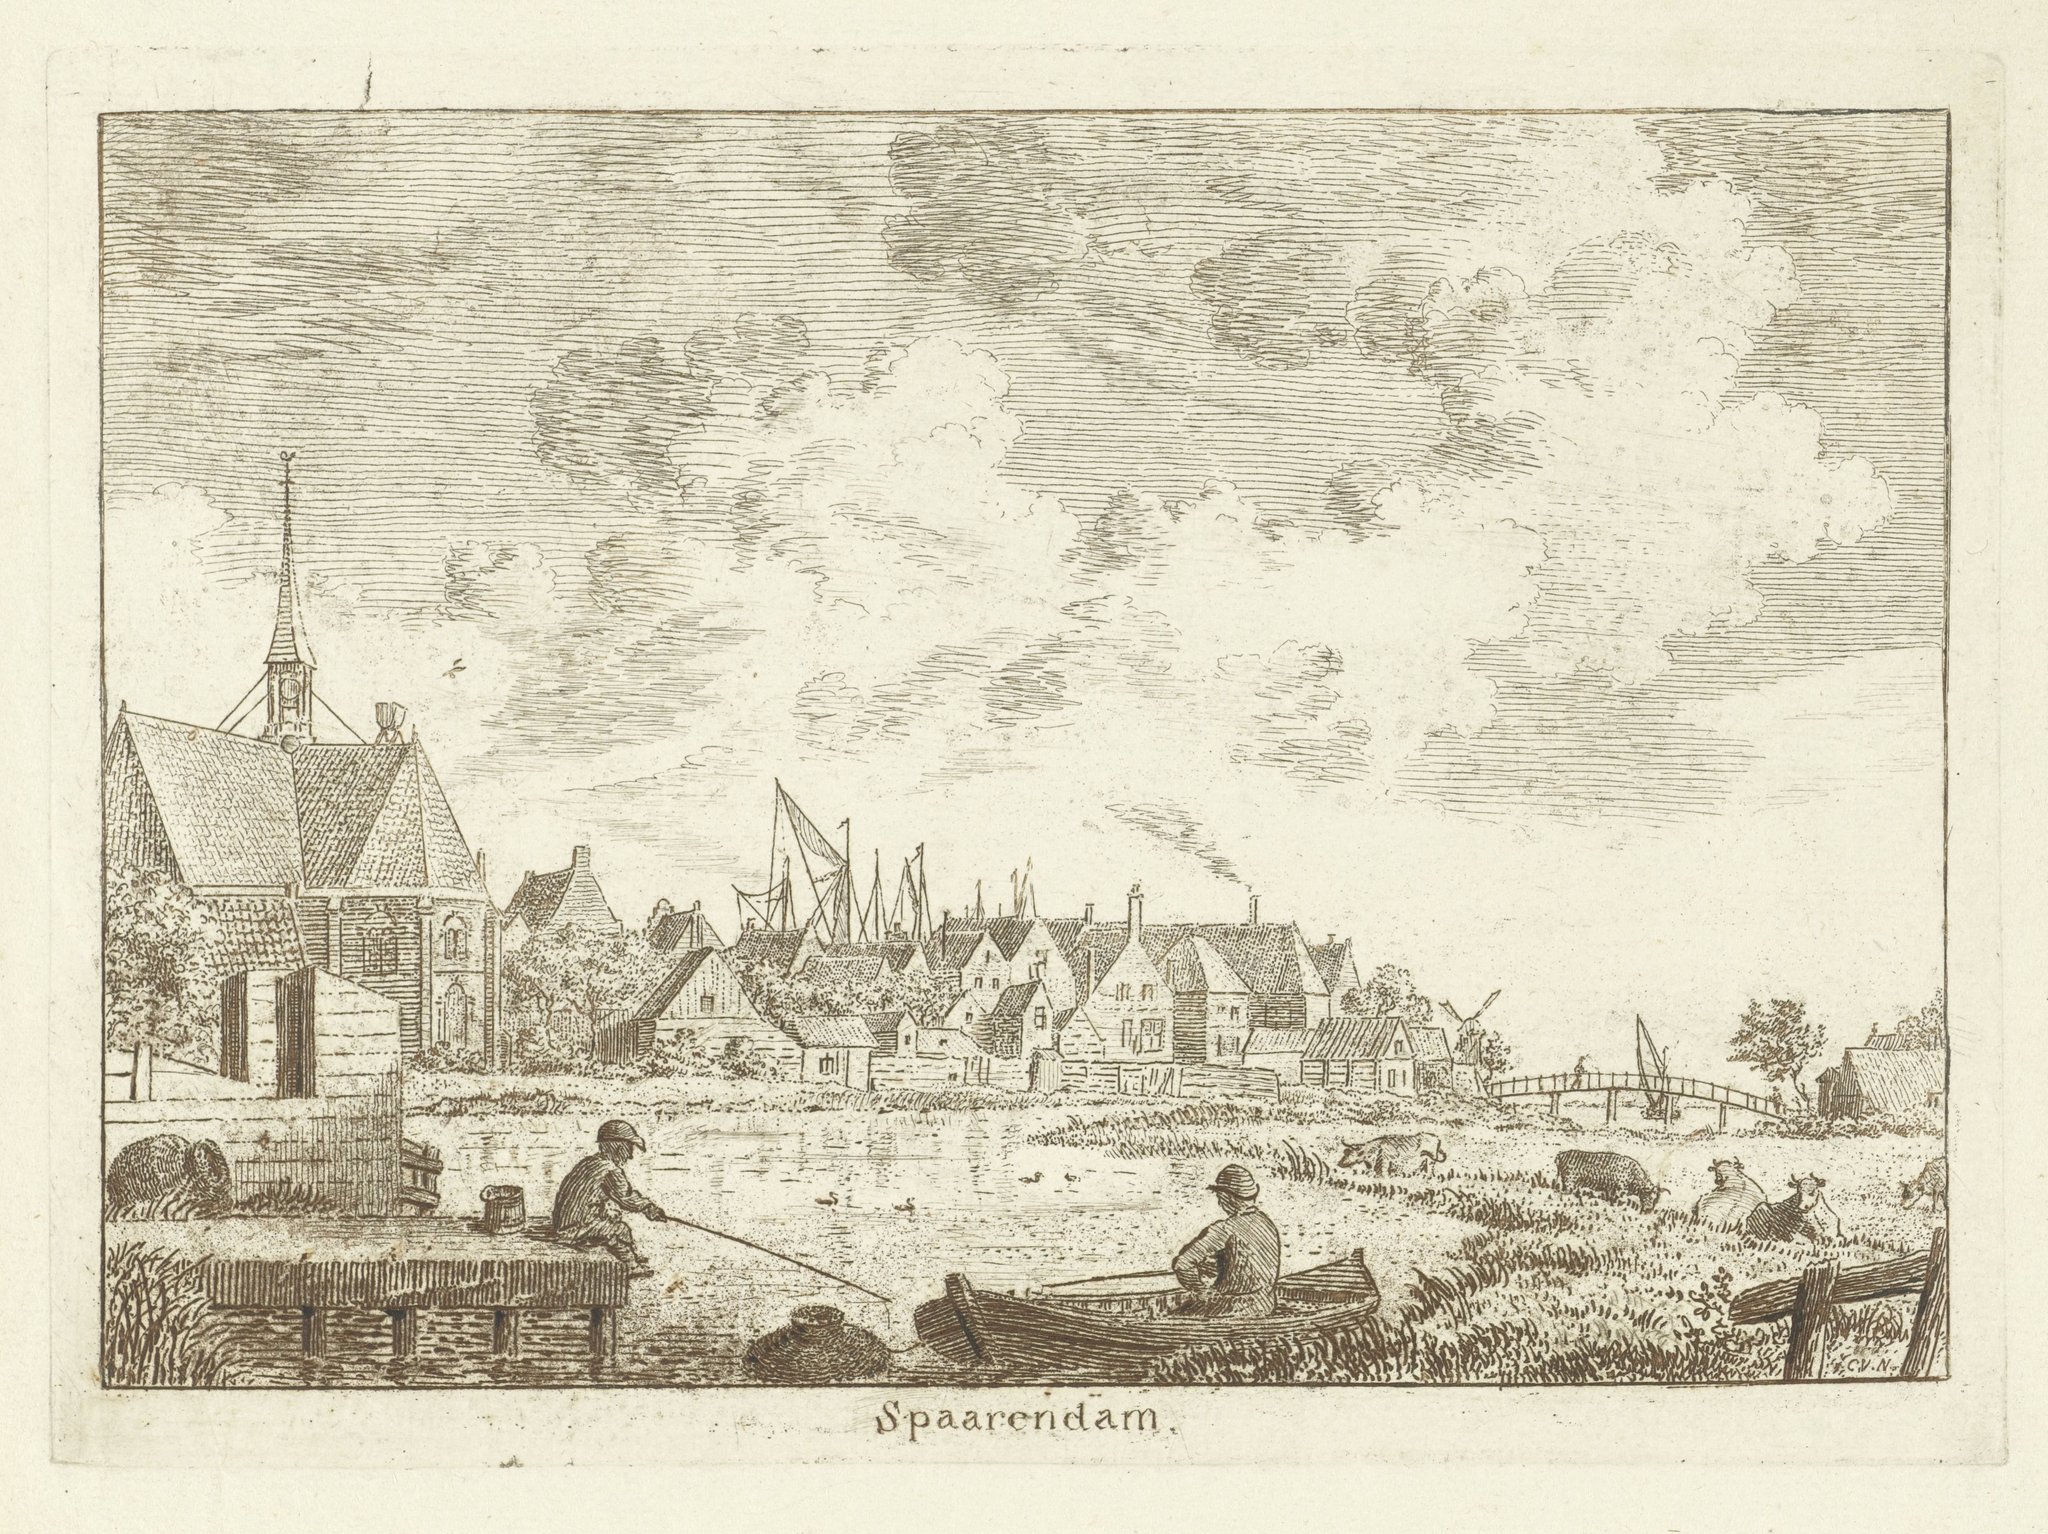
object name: print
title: Spaarendam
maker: cornelis van noorde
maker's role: draughtsman, print maker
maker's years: 1731-1795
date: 1741-1795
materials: paper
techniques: etching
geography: haarlem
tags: village, church (exterior), angling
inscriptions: collector's mark: Lugt 240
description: Gezicht op Spaarndam met links de Oude Kerk. Boven de huizen zijn masten van schepen zichtbaar. Op de voorgrond zitten twee hengelaars, één op de steiger en één in een roeiboot.